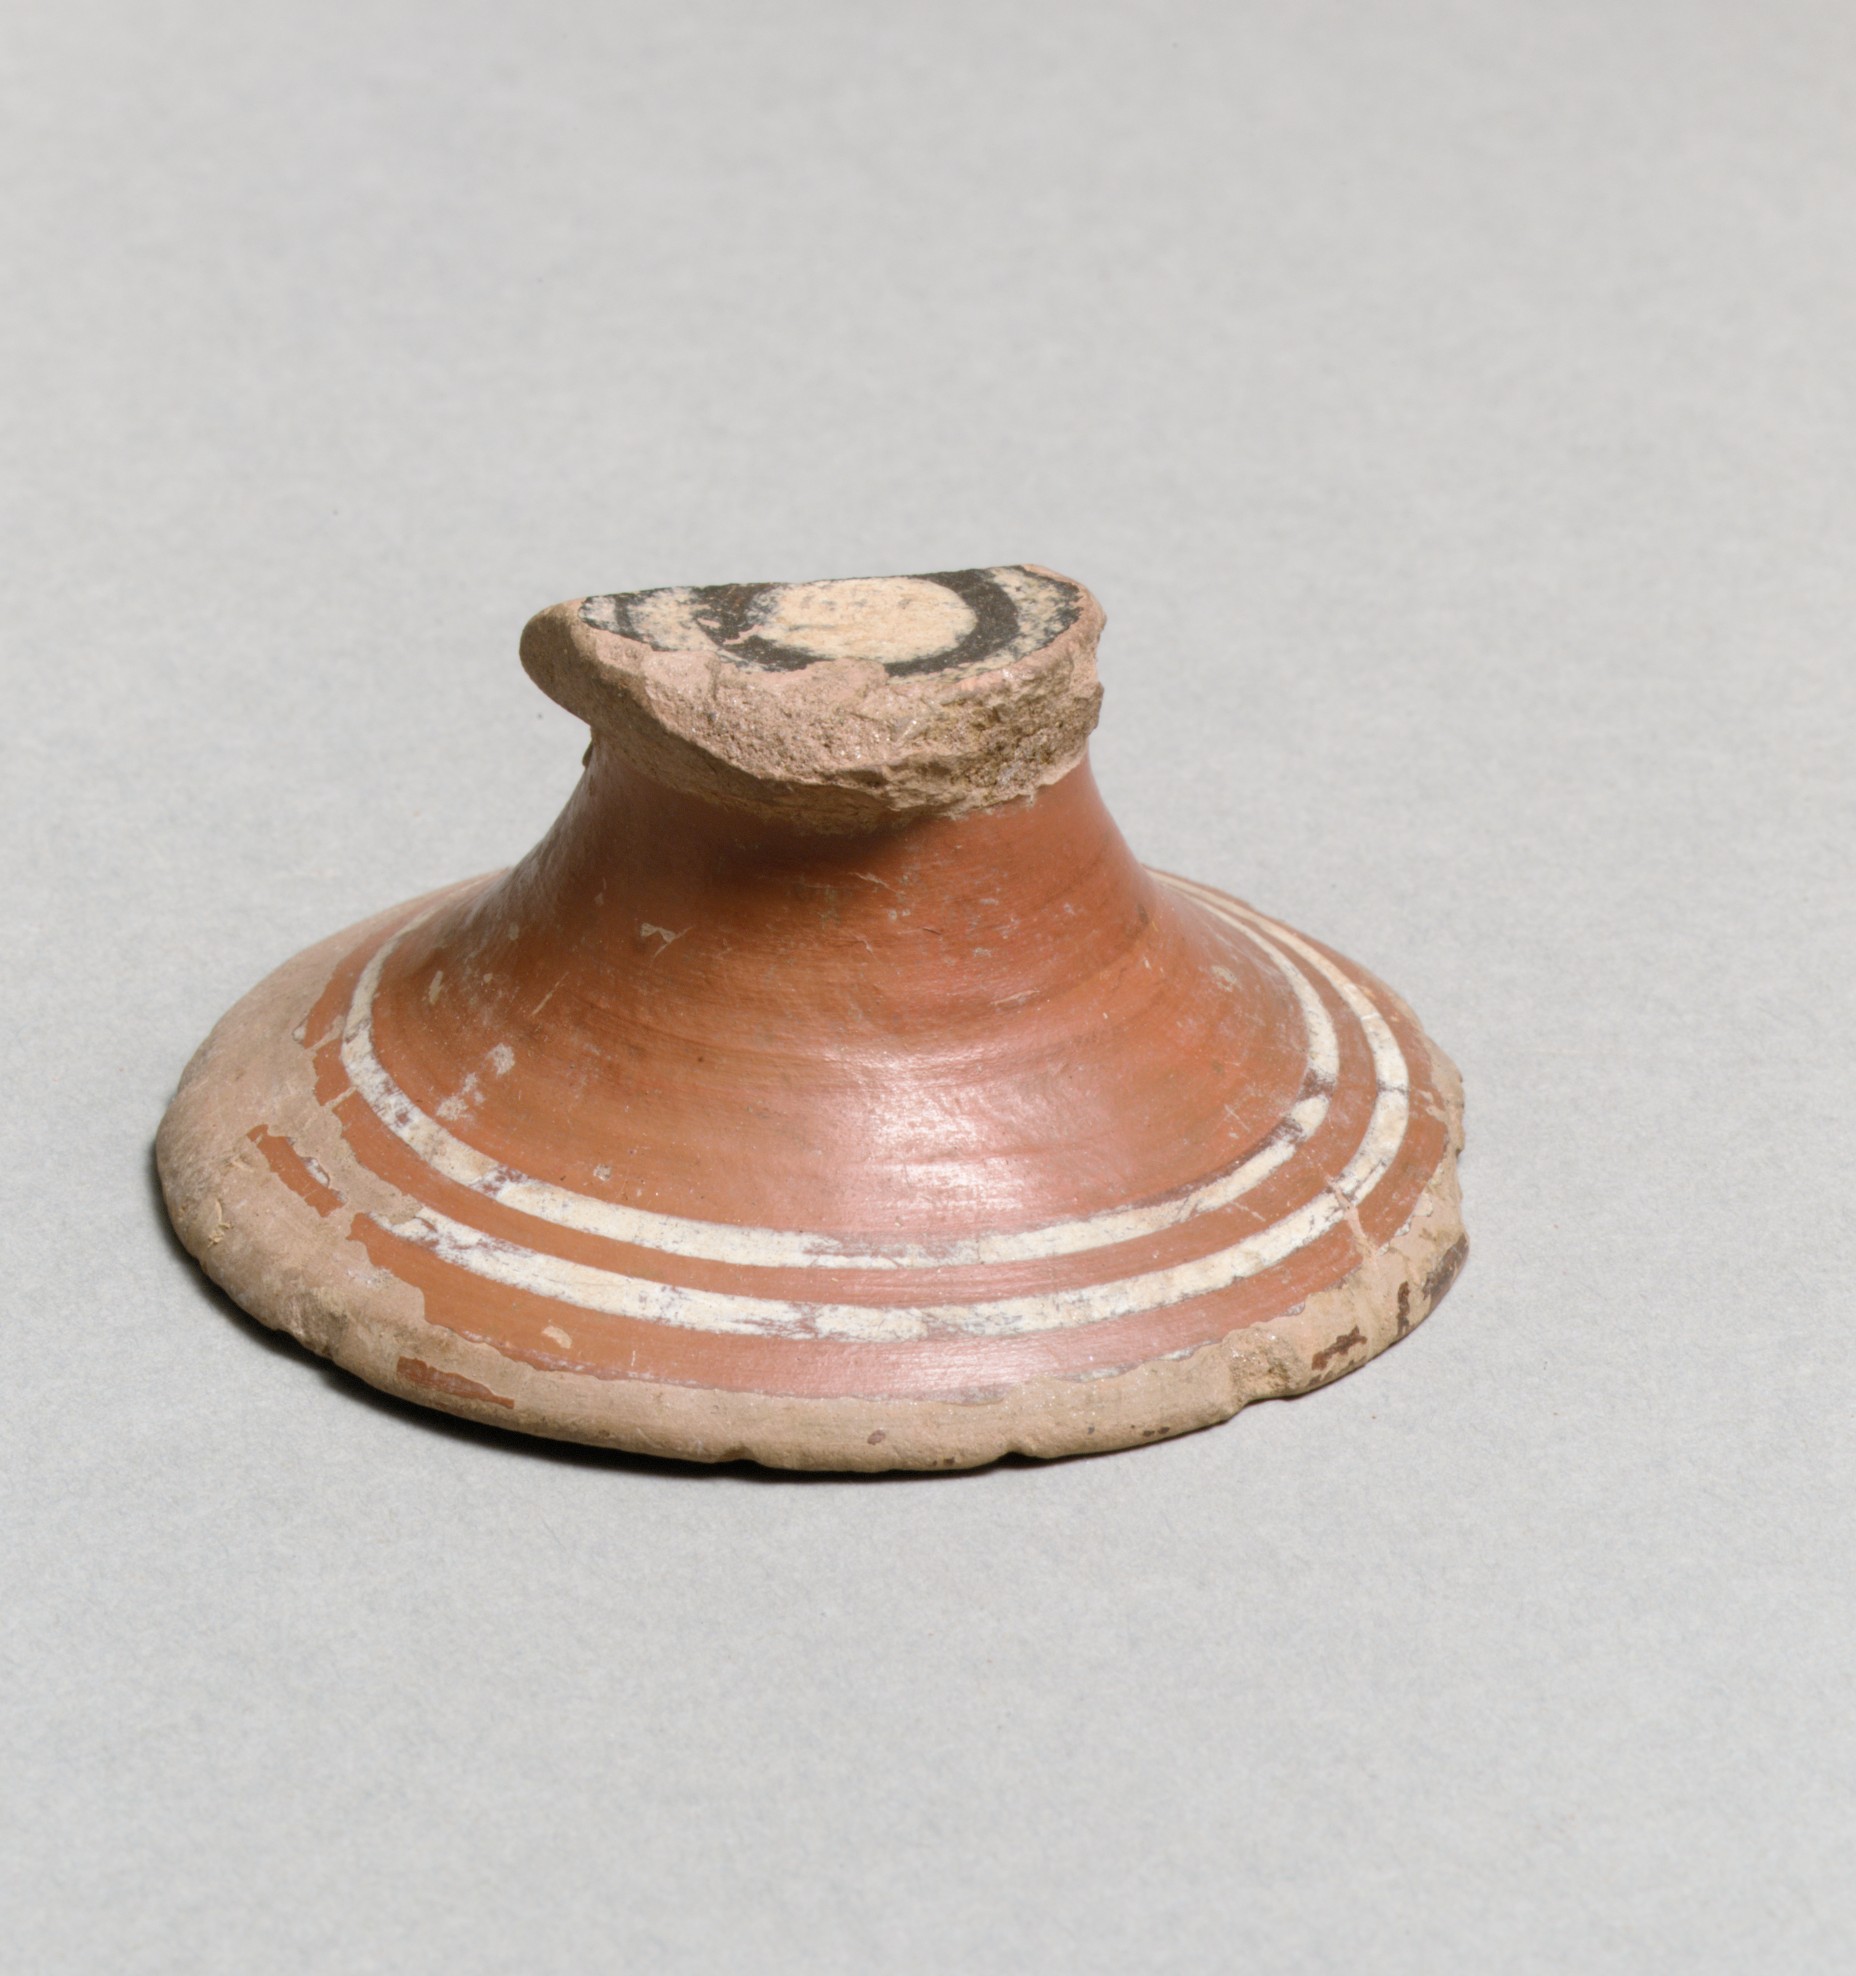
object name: vase fragment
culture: greek or lydian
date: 900-30 BCE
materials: terracotta